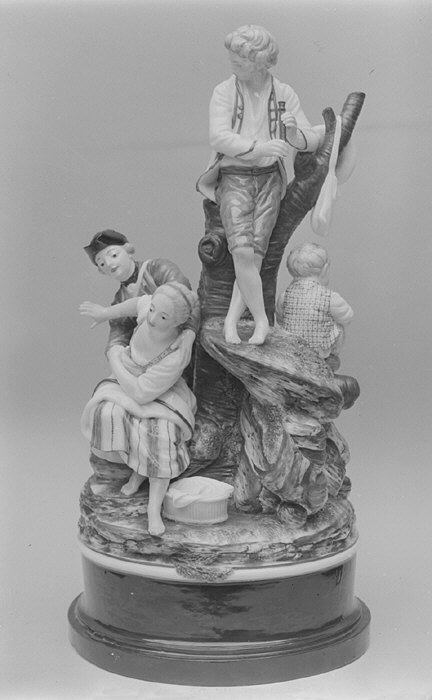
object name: group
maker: niderviller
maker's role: factory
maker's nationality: french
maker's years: 1735-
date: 1780-1800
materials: hard paste porcelain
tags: children,men,women